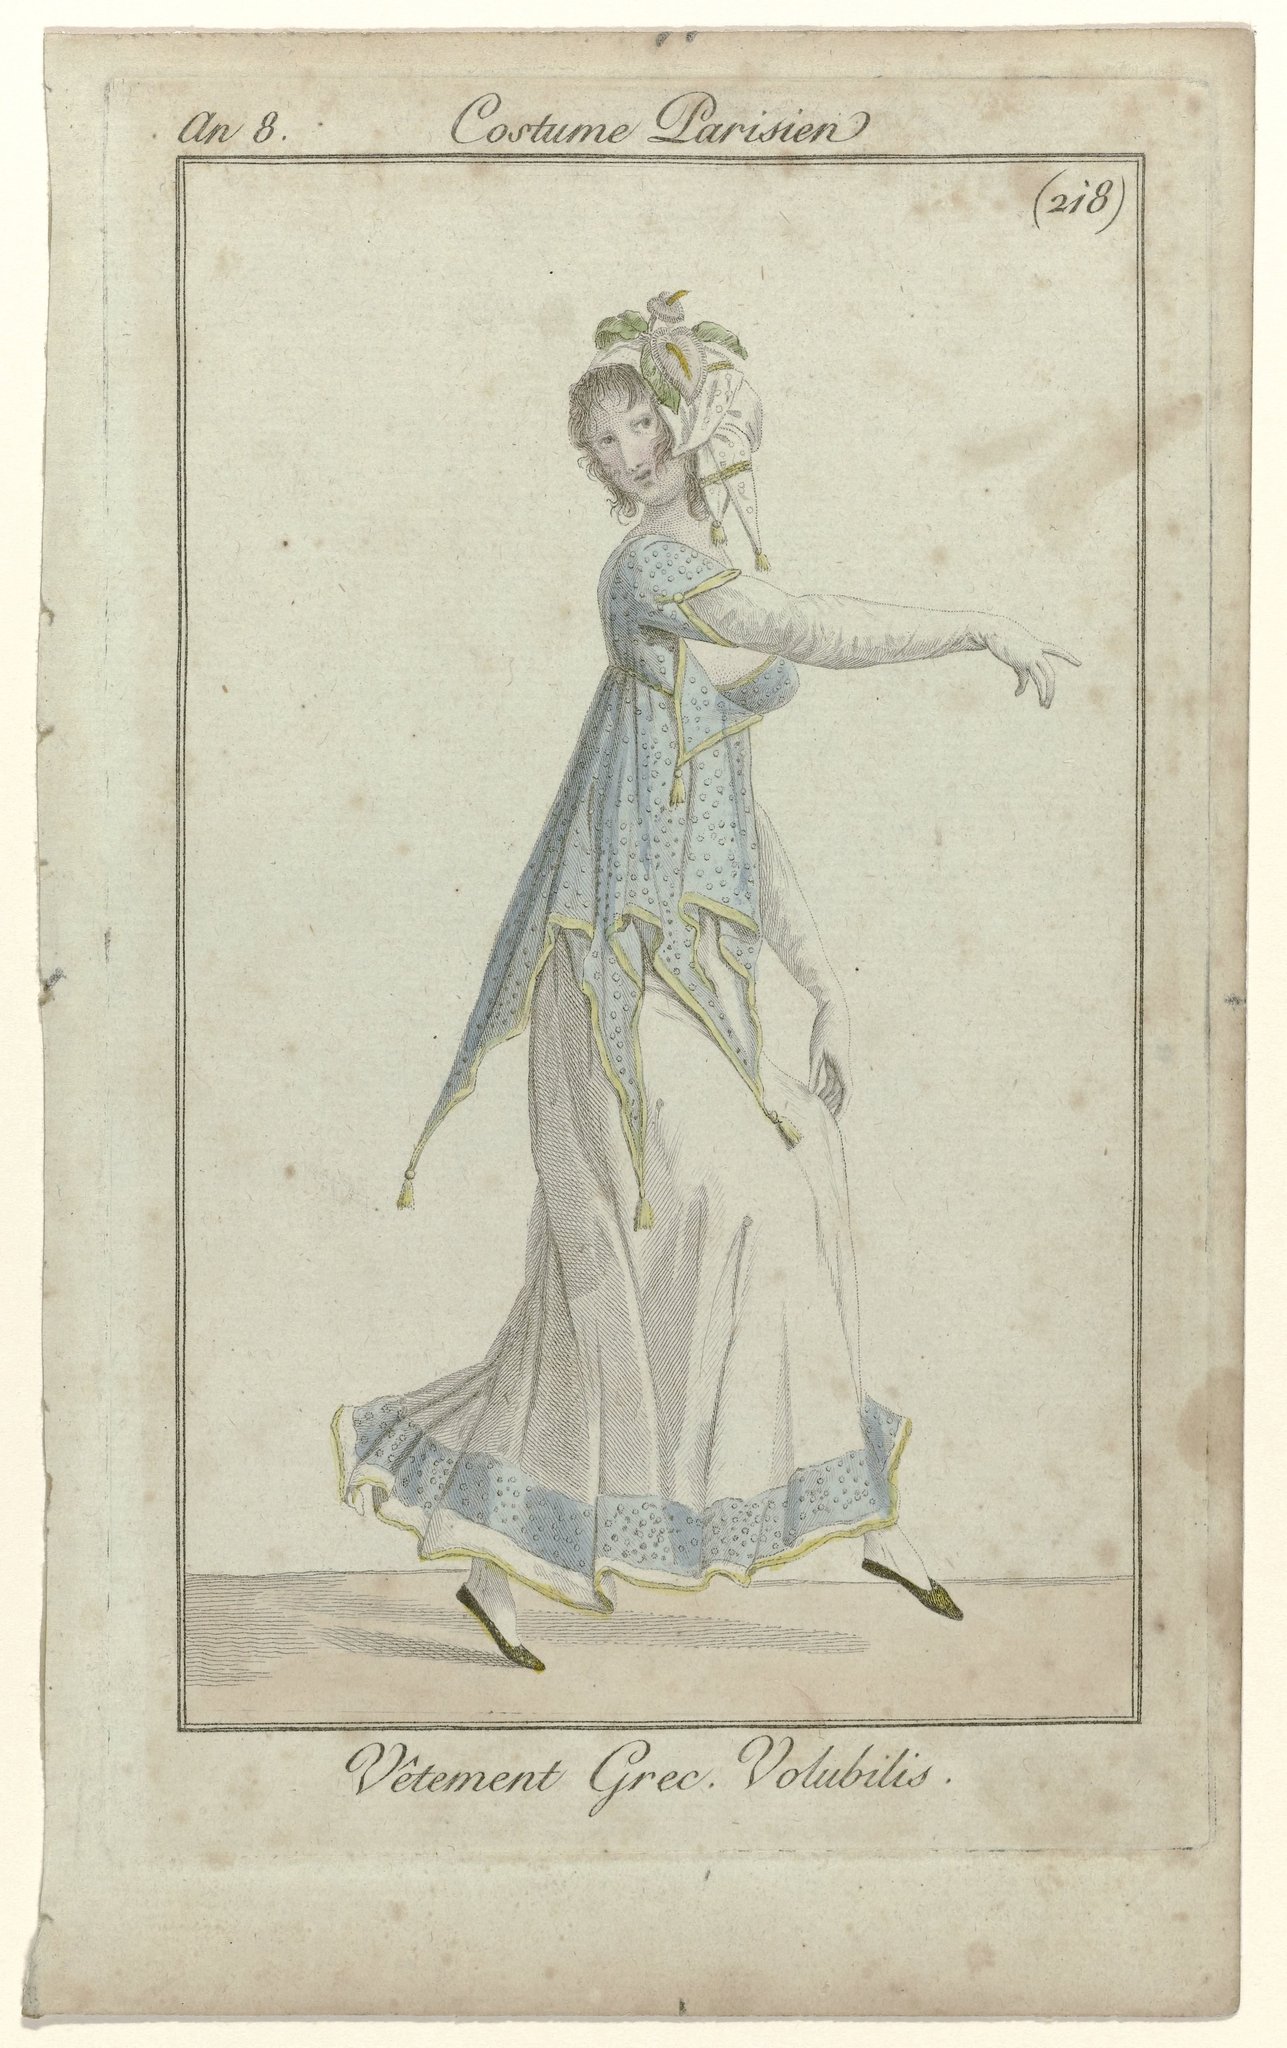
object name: fashion print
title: Journal des Dames et des Modes, Costume Parisien, 25 mai 1800, An 8 (218) : Vêtement Grec. Volubilis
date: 1800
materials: paper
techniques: engraving, hand coloring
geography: paris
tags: cut flowers; nosegay, bunch of flowers, clothing for the upper part of the body (tunic) (+ women's clothes), head-gear: cap (+ women's clothes), fashion plates, shoes, sandals (+ women's clothes), skirt (+ women's clothes)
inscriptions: title: ‘Costume Parisien.’, caption: ‘Vêtement Grec. Volubilis’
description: Dansende vrouw gekleed in een ensemble: 'Vêtement Grec. Volubilis'. Zij draagt een gestippelde tuniek, in punten uitlopend, versierd met bies en kwasten, op een rok afgezet met bijpassende versiering. Kousen. Accessoires: gestippelde muts(?) met bloemen, lange handschoenen, platte schoenen. De prent maakt deel uit van het modetijdschrift Journal des Dames et des Modes, uitgegeven door Pierre de la Mésangère, Parijs, 1797-1839.